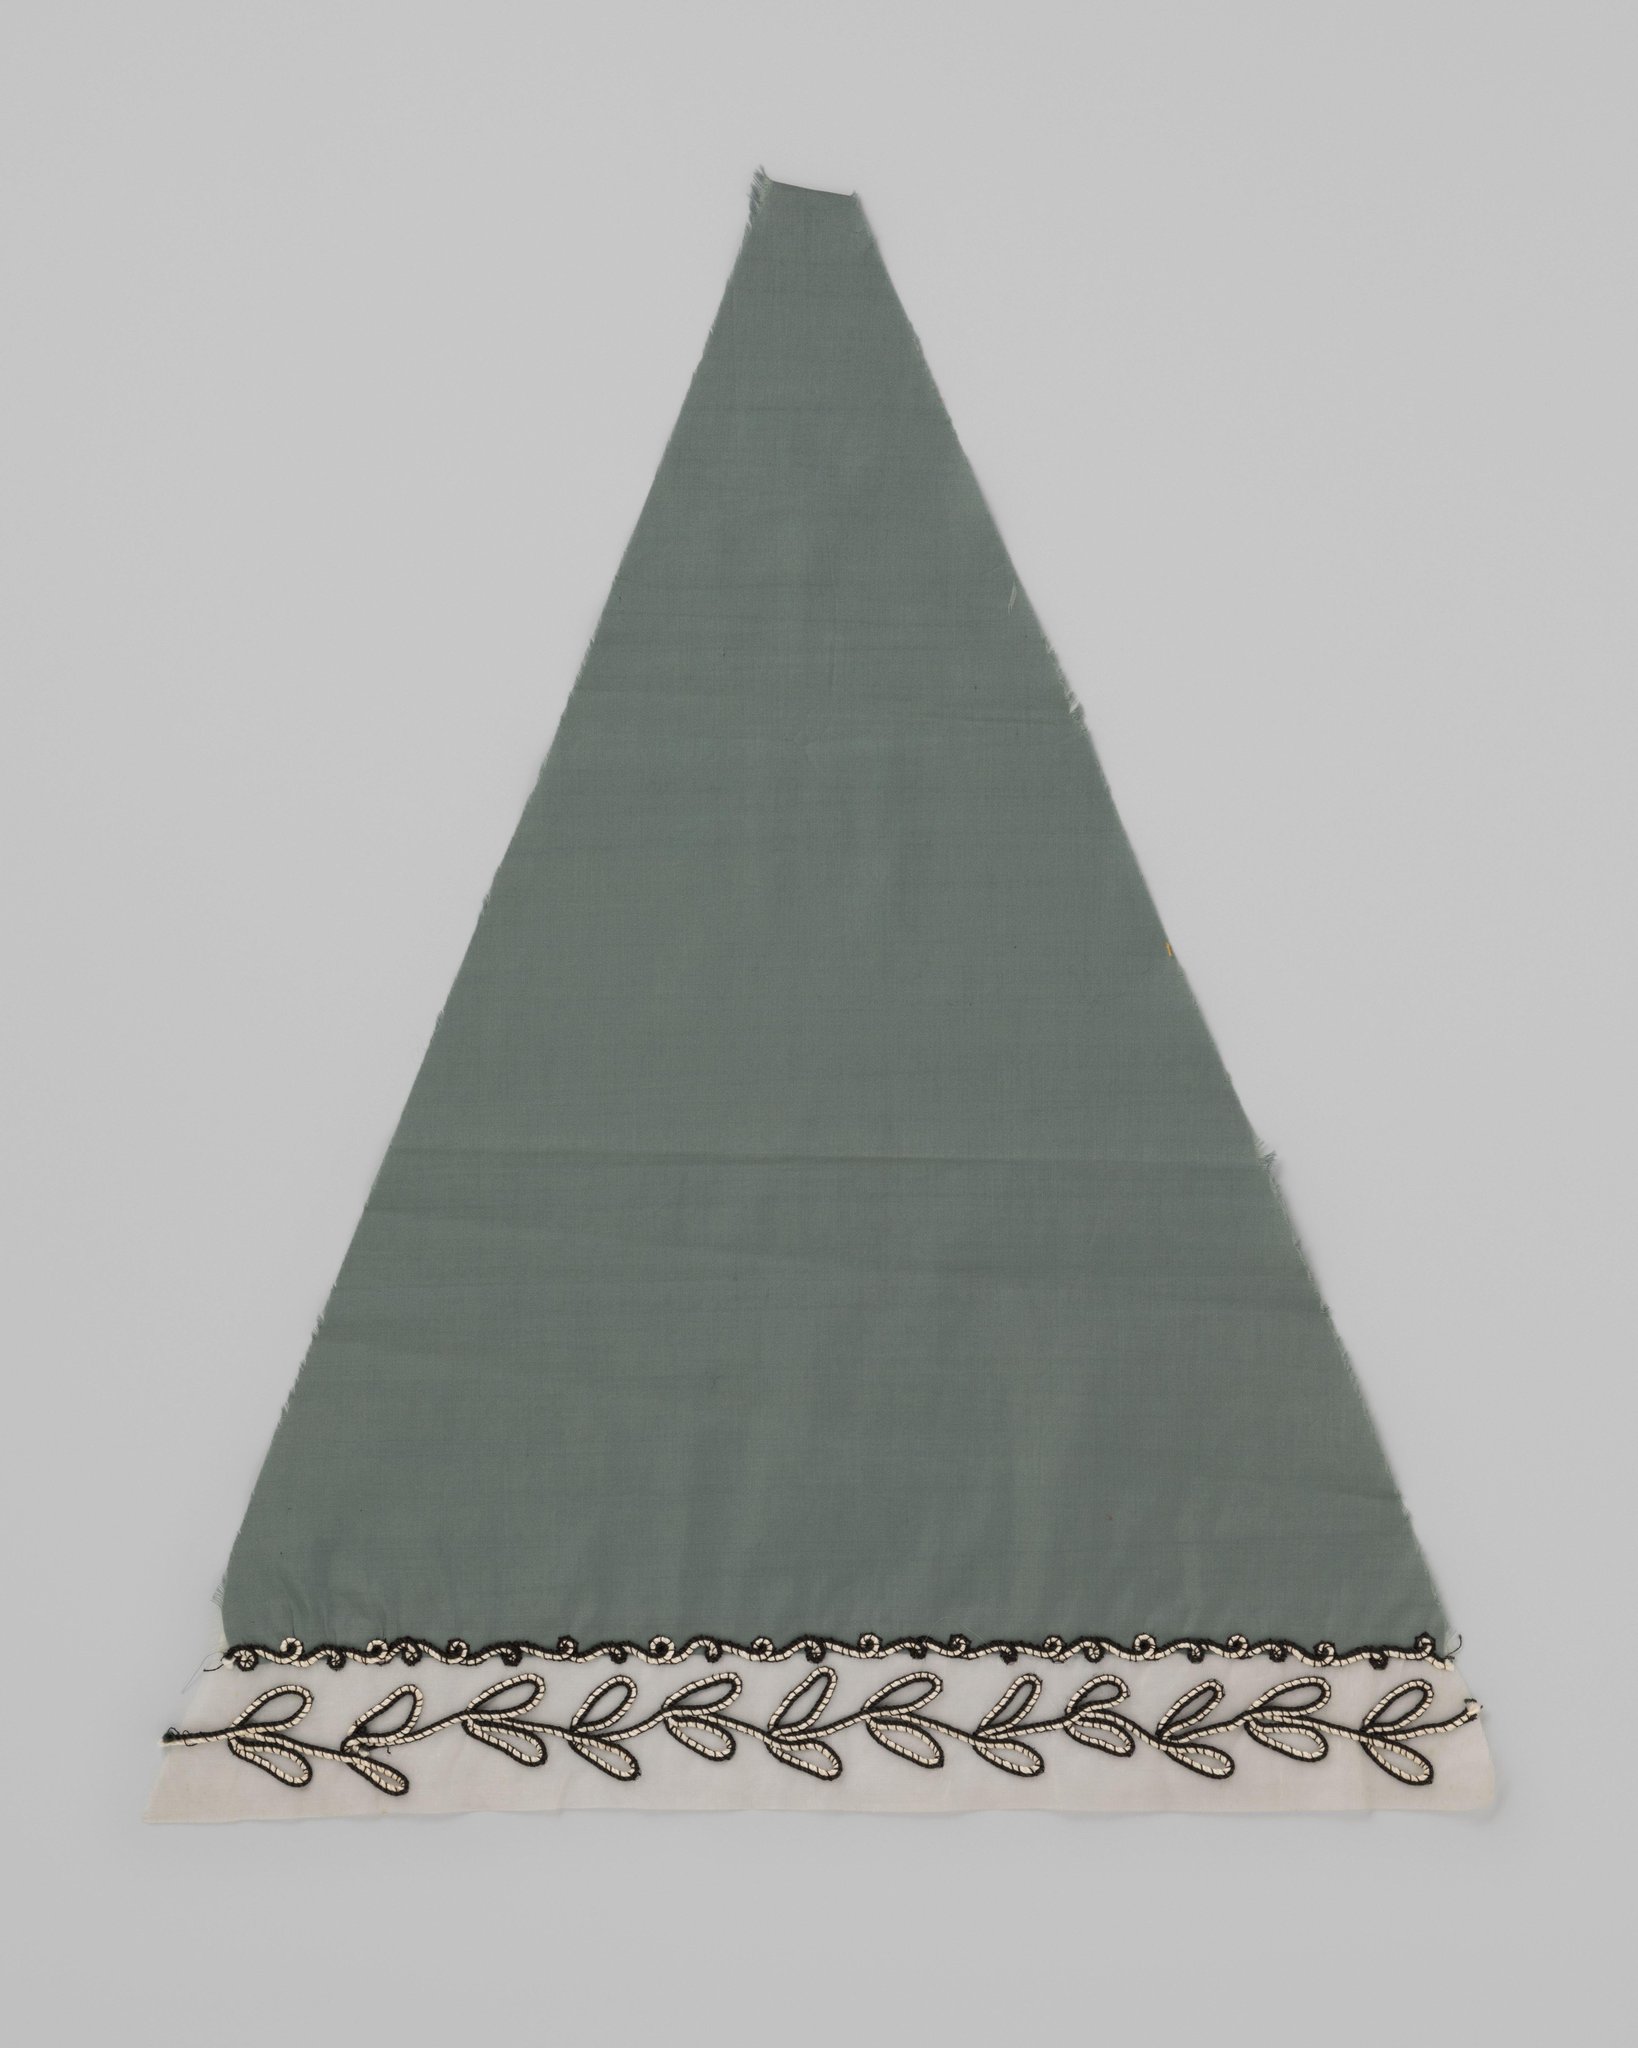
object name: parasoldek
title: Sector van een parasoldek van zachtgroene katoen, met een met woldraad geborduurde batisten rand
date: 1885-1900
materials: cotton, wool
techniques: embroidered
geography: france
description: Sector van een parasoldek van zachtgroene katoen, met een met woldraad geborduurde batisten rand.